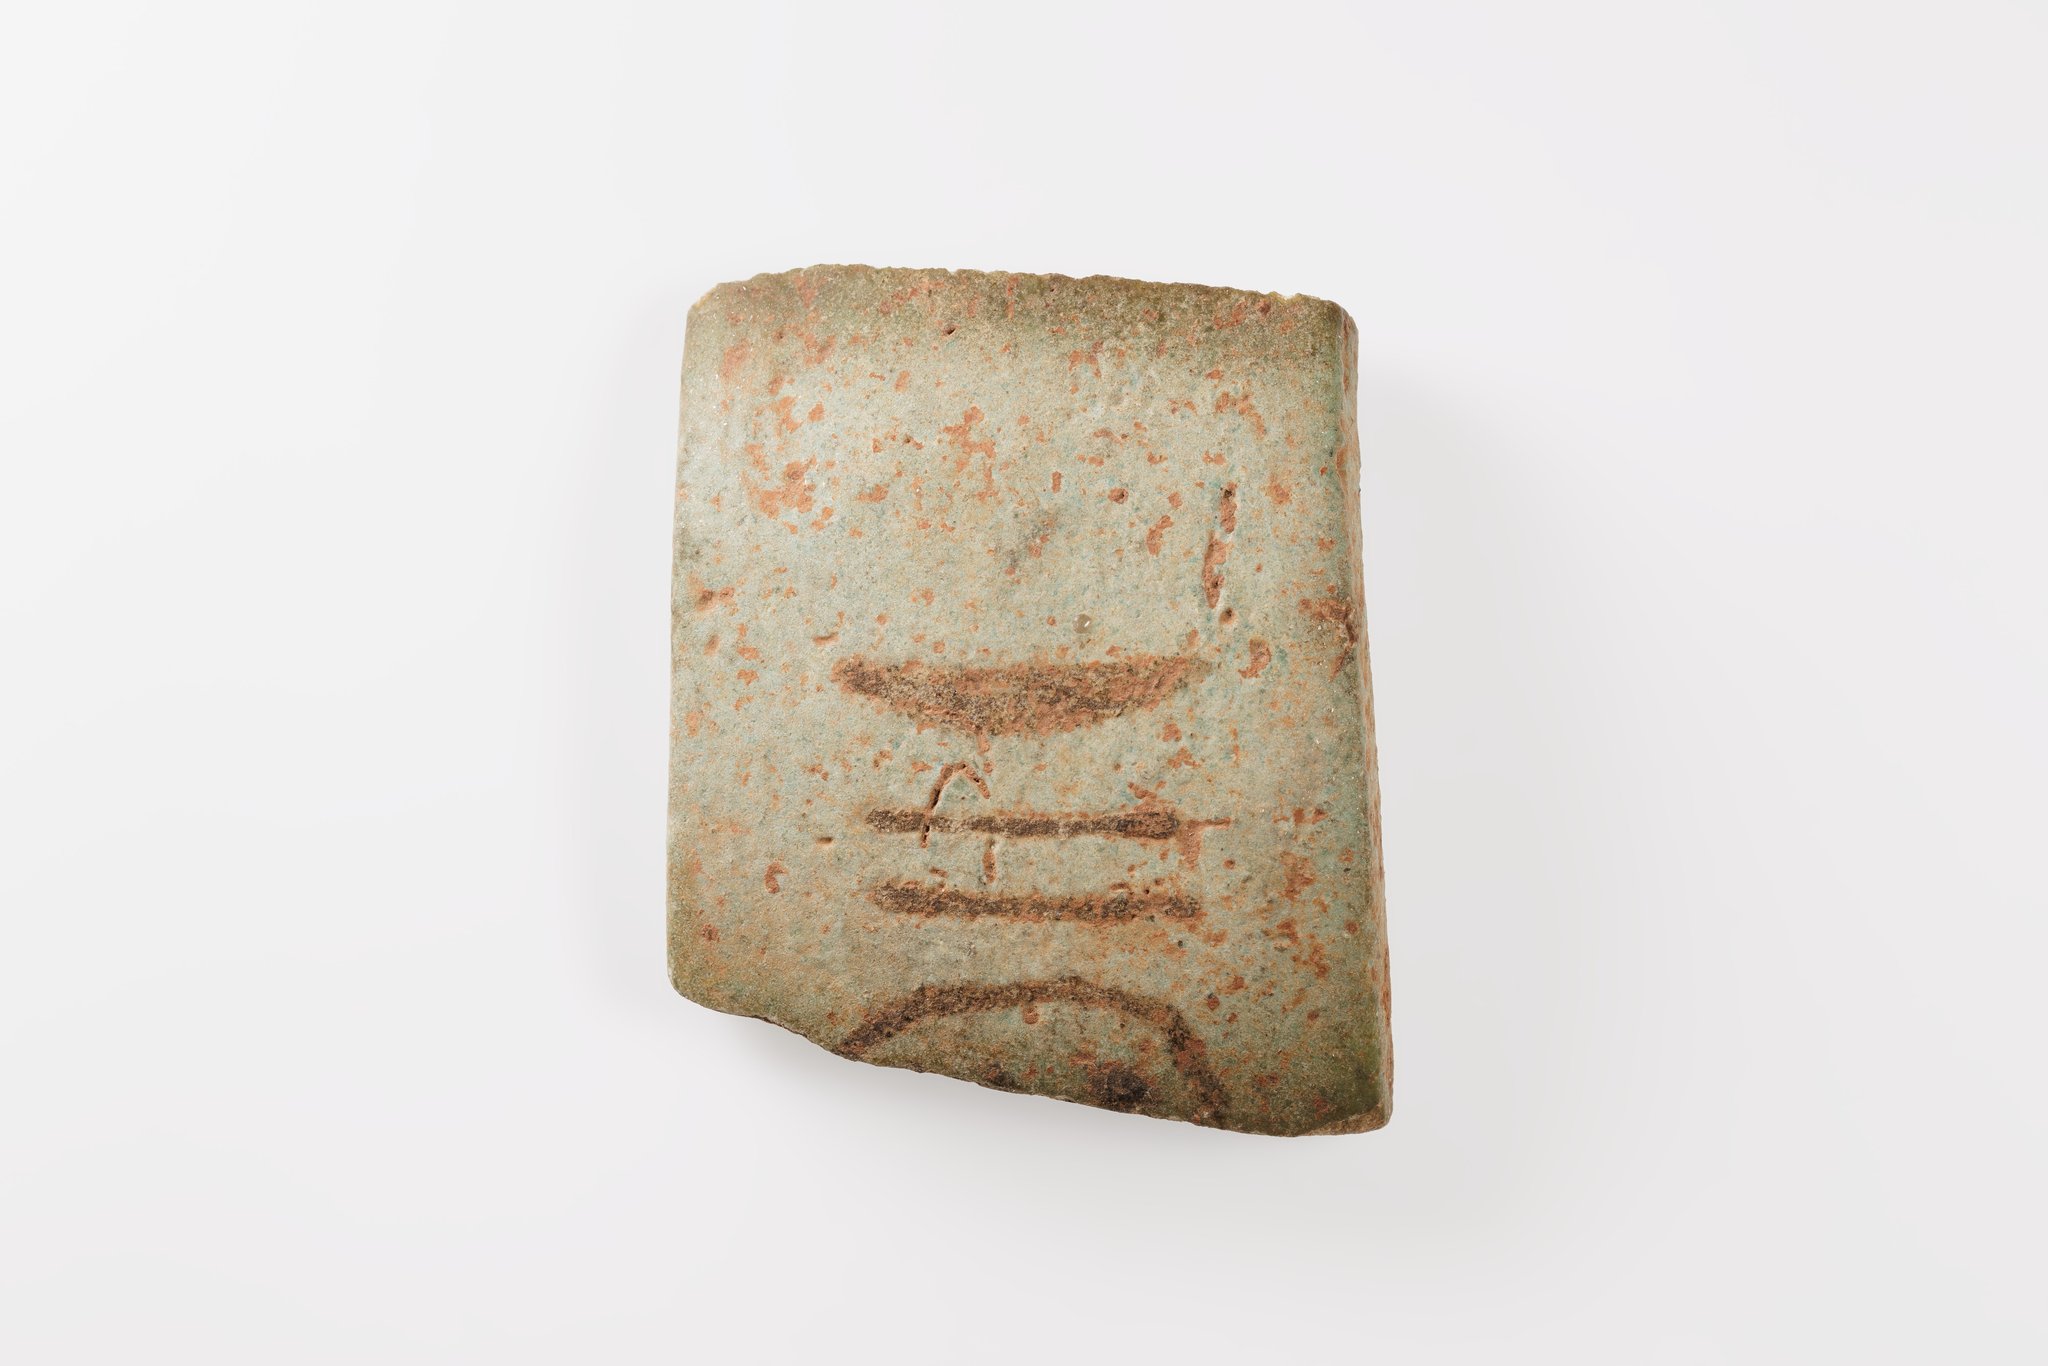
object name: votive bracelet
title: Fragment of a votive bracelet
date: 1295-1070 BCE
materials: faience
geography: egypt